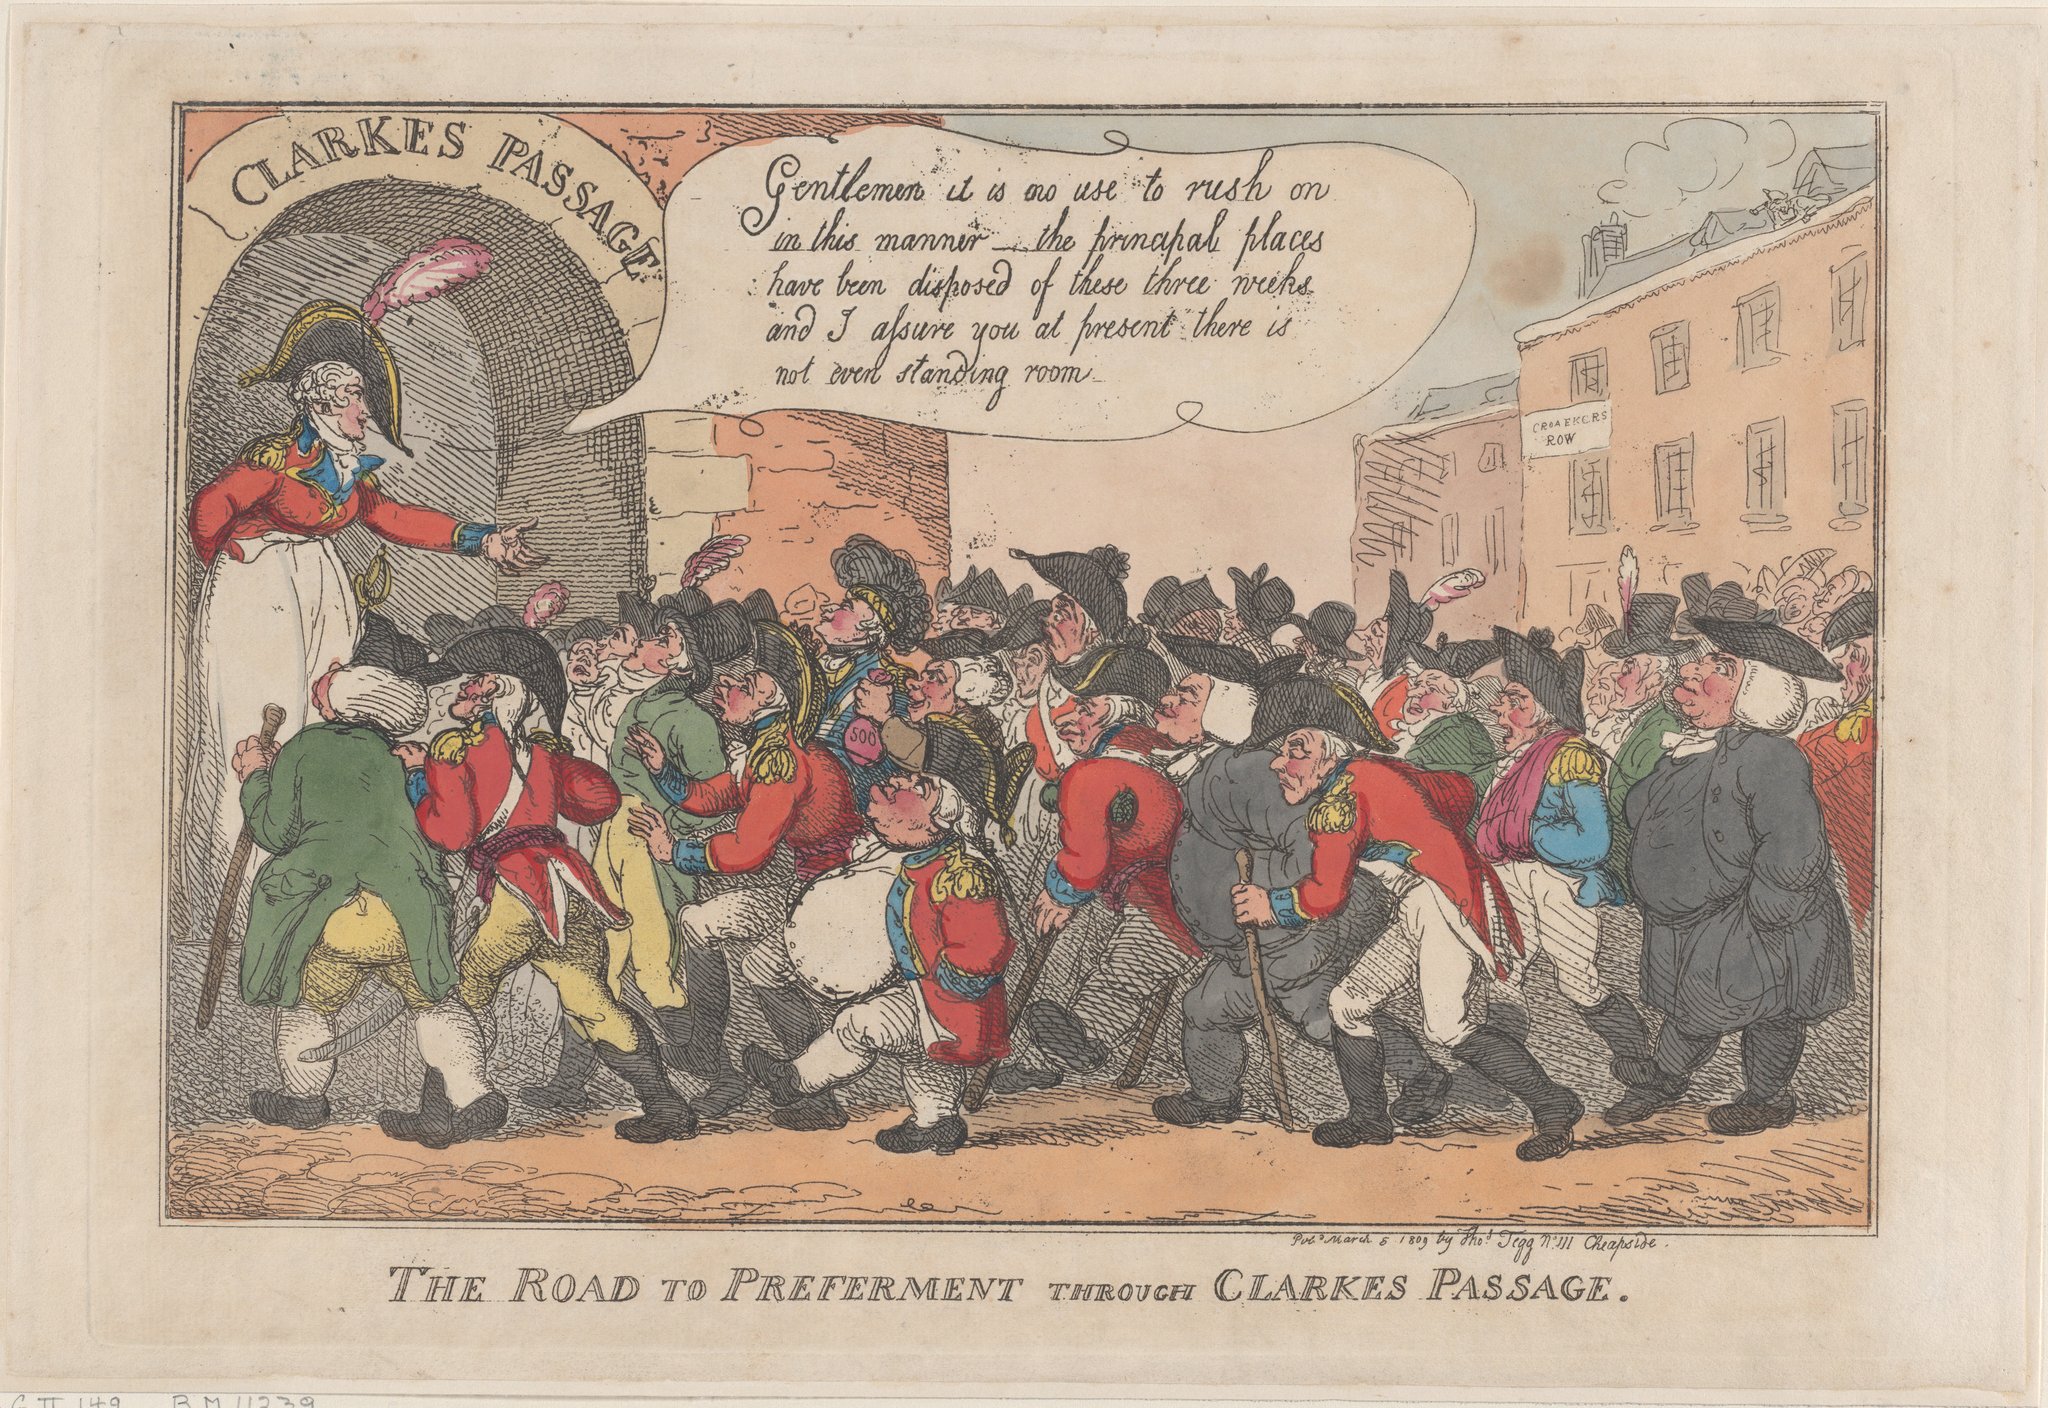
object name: print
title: The Road to Preferment Through Clarke's Passage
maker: thomas rowlandson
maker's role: artist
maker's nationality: british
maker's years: 1757-1827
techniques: etching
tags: satire,soldiers,men,politics